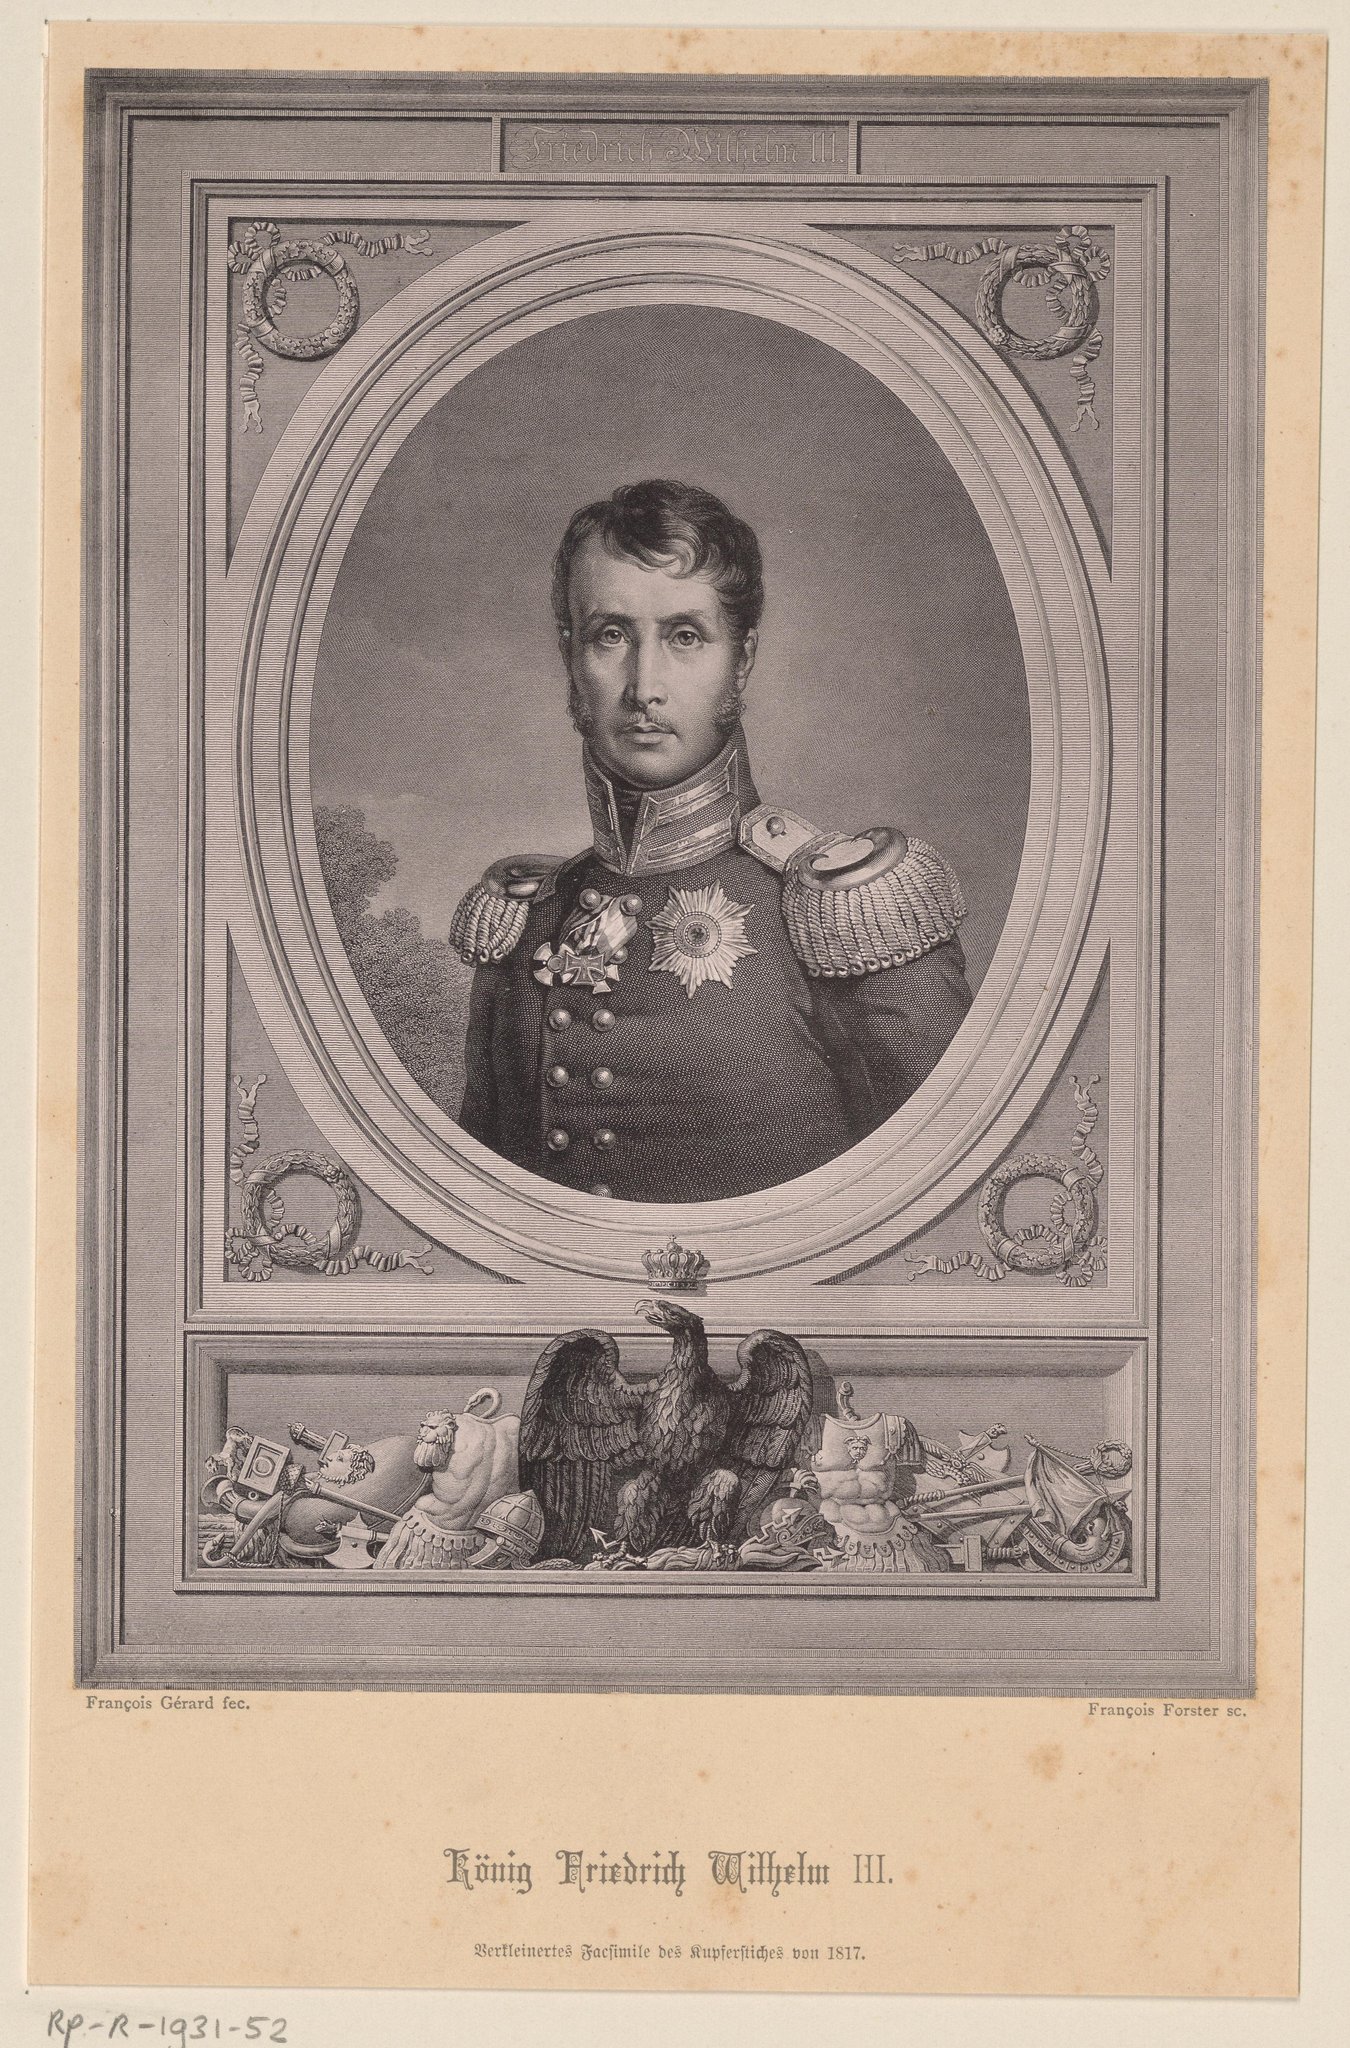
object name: photomechanical print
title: Portret van Frederik Willem III van Pruisen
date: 1875-1930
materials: paper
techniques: photograph, snipping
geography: germany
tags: berlin, frederik willem iii koning van pruisen, crown (symbol of sovereignty), historical persons, (military) uniforms, king